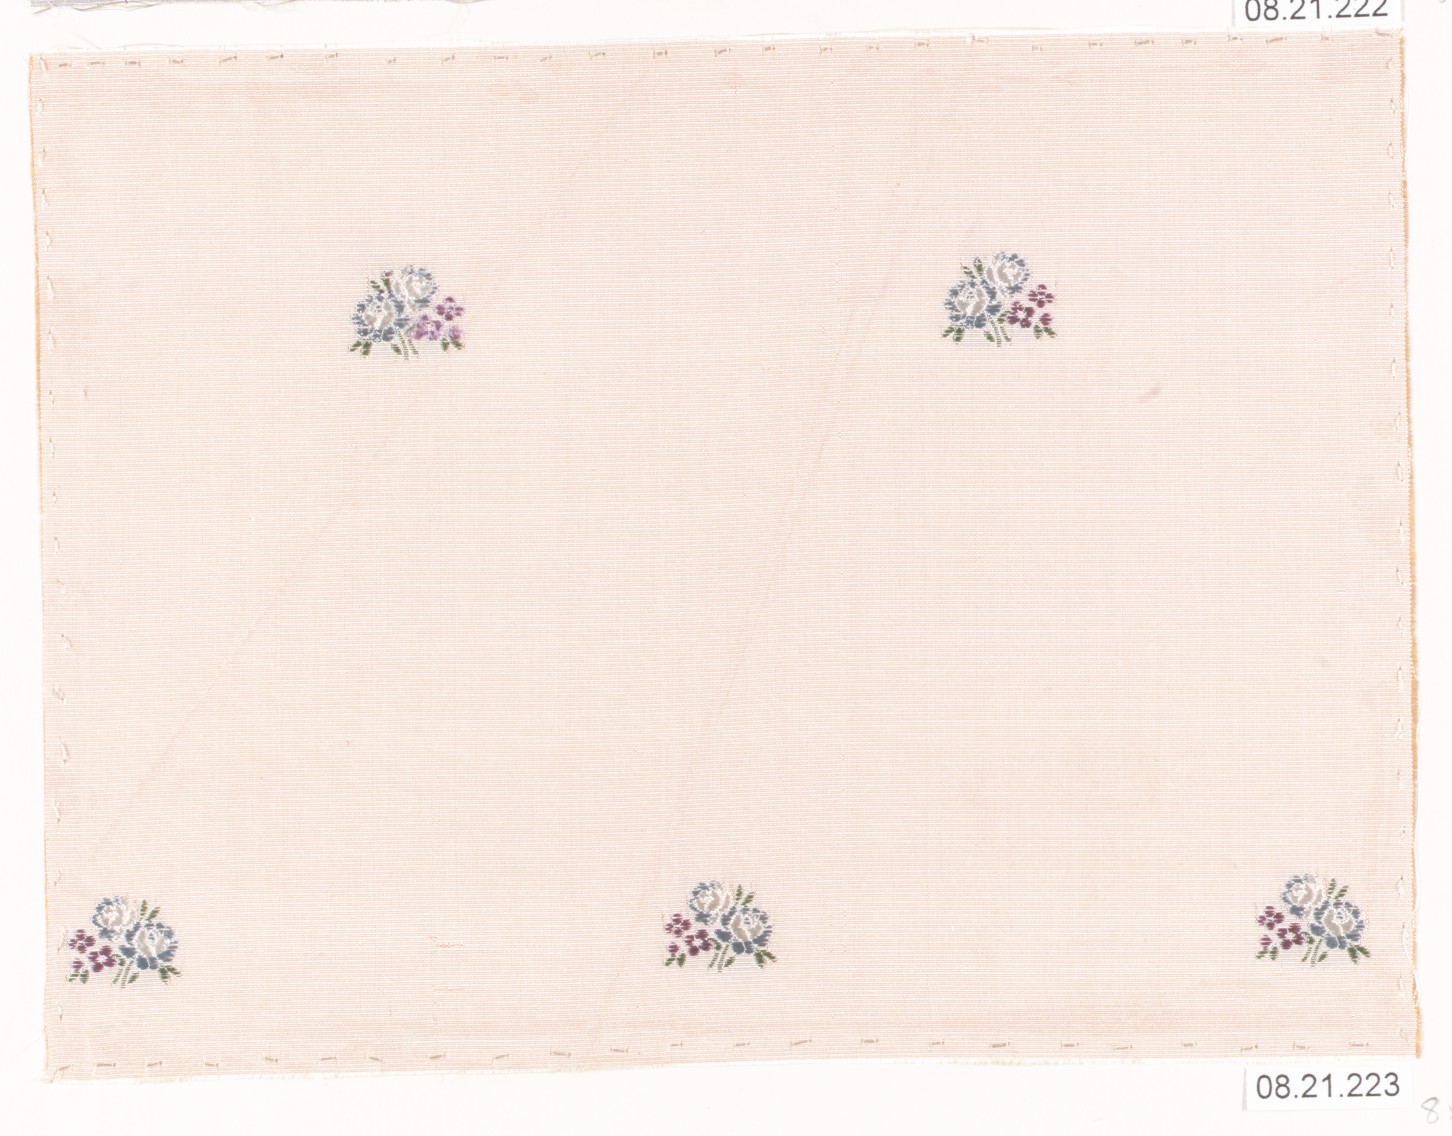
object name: textile sample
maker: Anonymous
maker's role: designer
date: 1900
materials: silk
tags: flowers